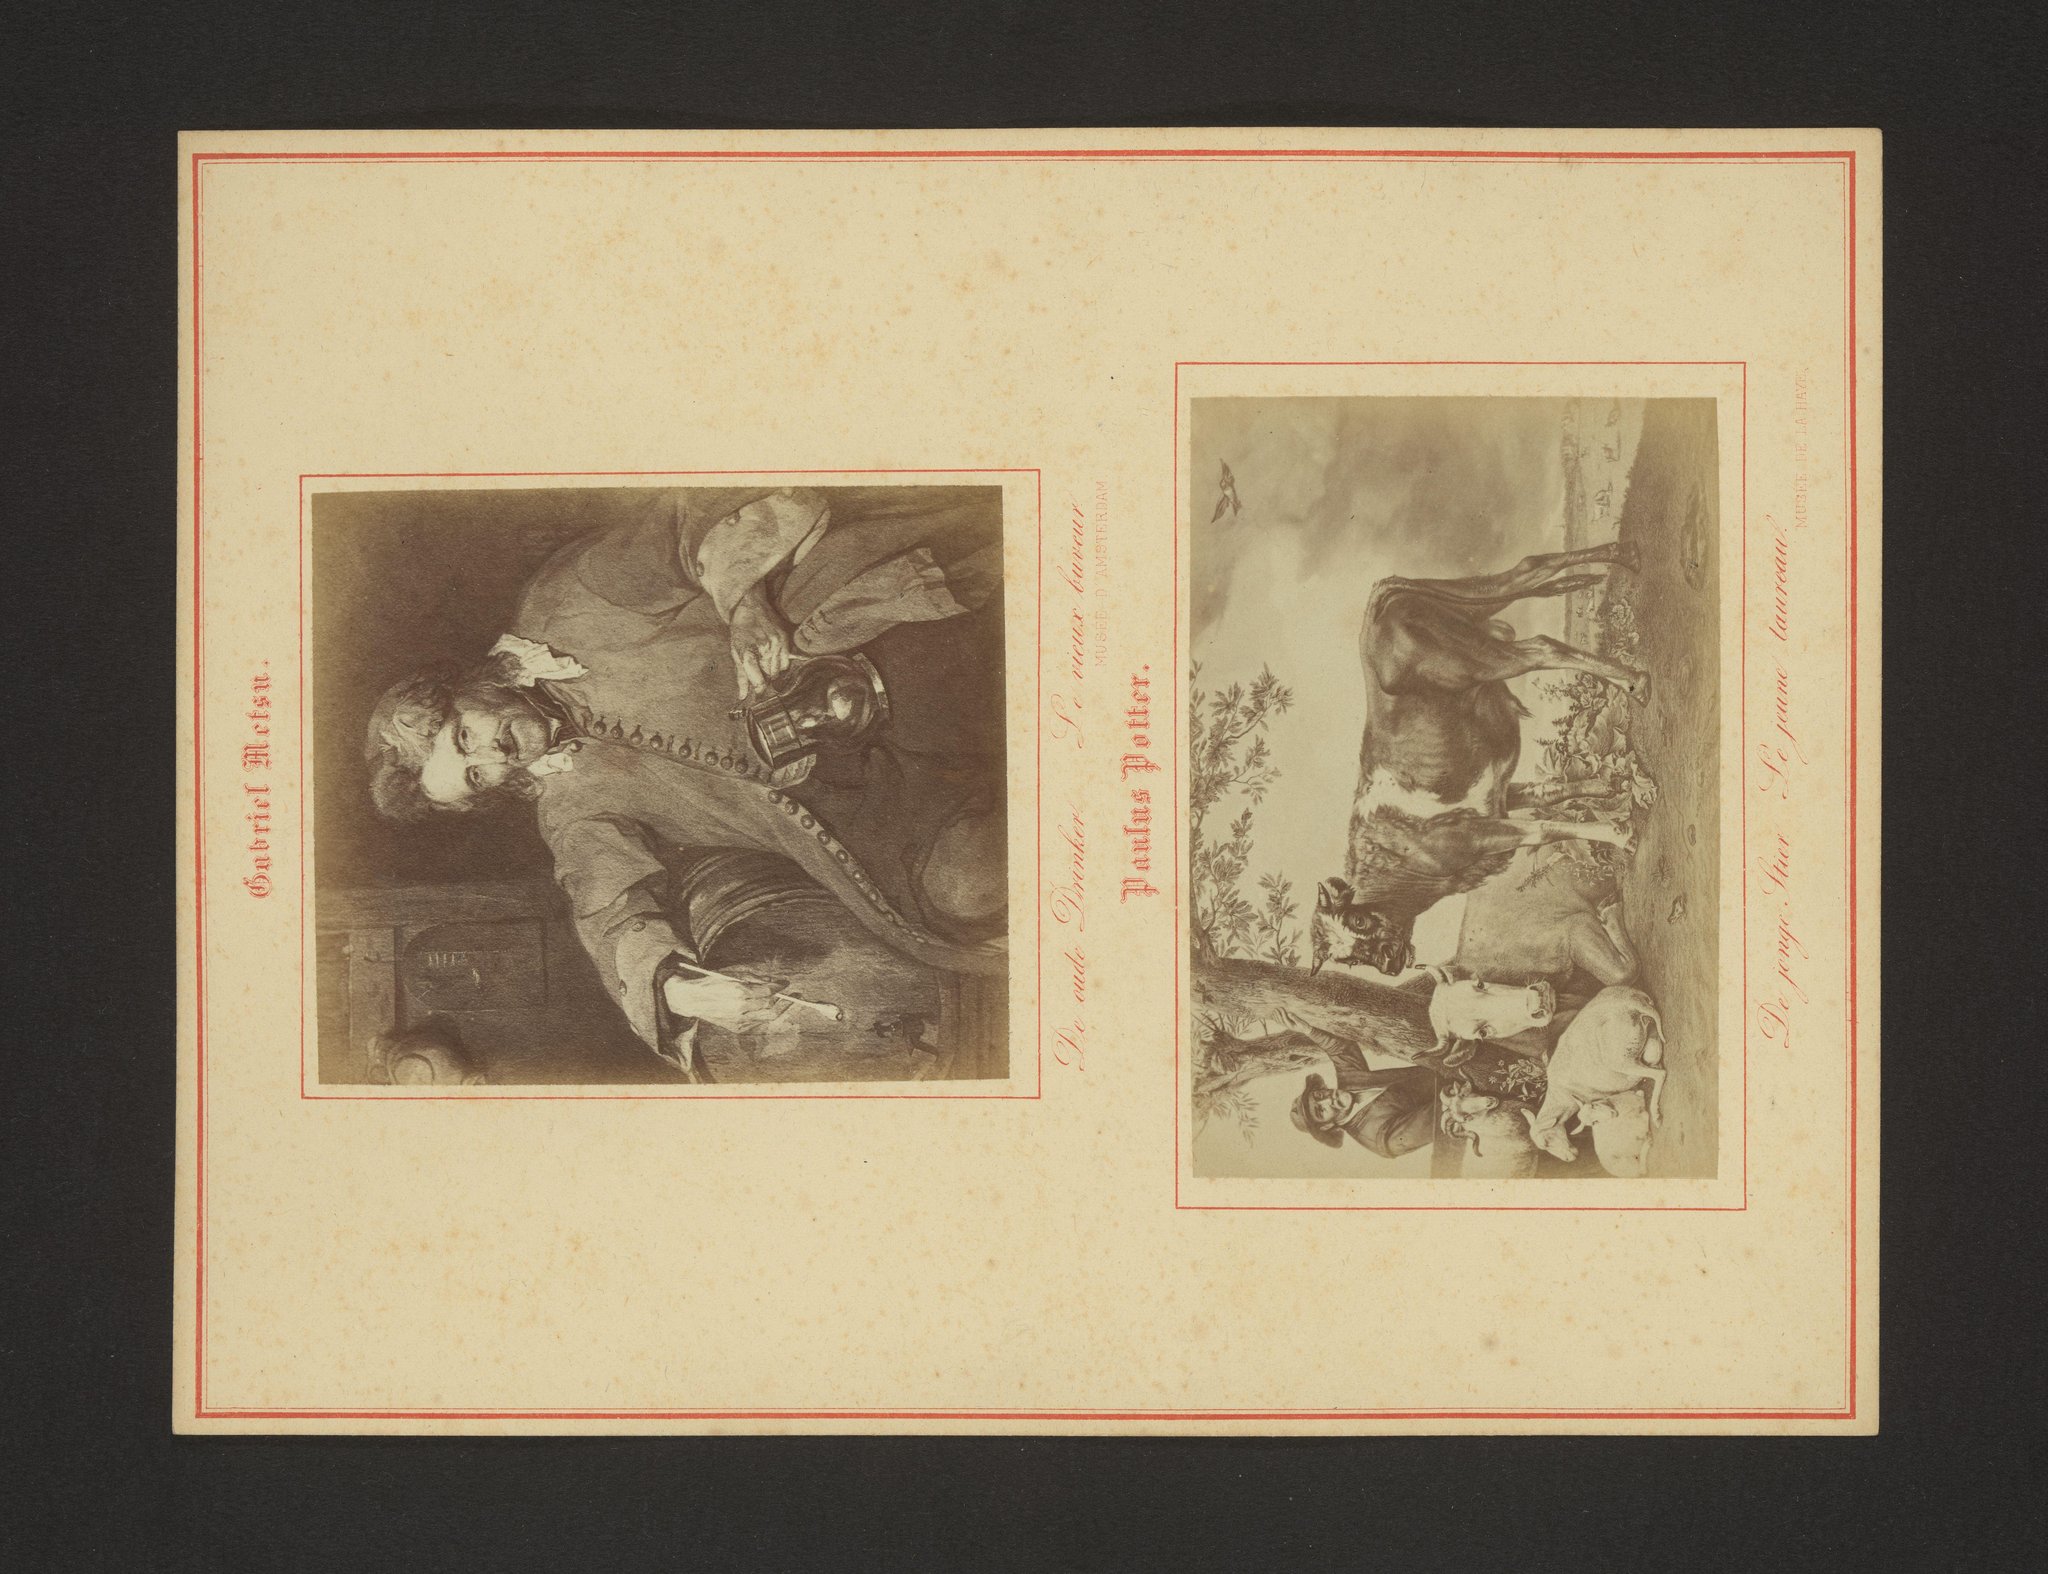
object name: reproduction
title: Fotoreproducties van De oude drinker door Gabriël Metsu en De stier door Paulus Potter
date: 1866-1874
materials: cardboard, photographic support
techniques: albumen print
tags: historical persons, pipe ~ tobacco, old man, drinking, bovine cattle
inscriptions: annotation: ‘Musée d'Amsterdam’, annotation: ‘Musée de La Haye’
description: Deze foto maakt deel uit van een omslag met 25 foto's.